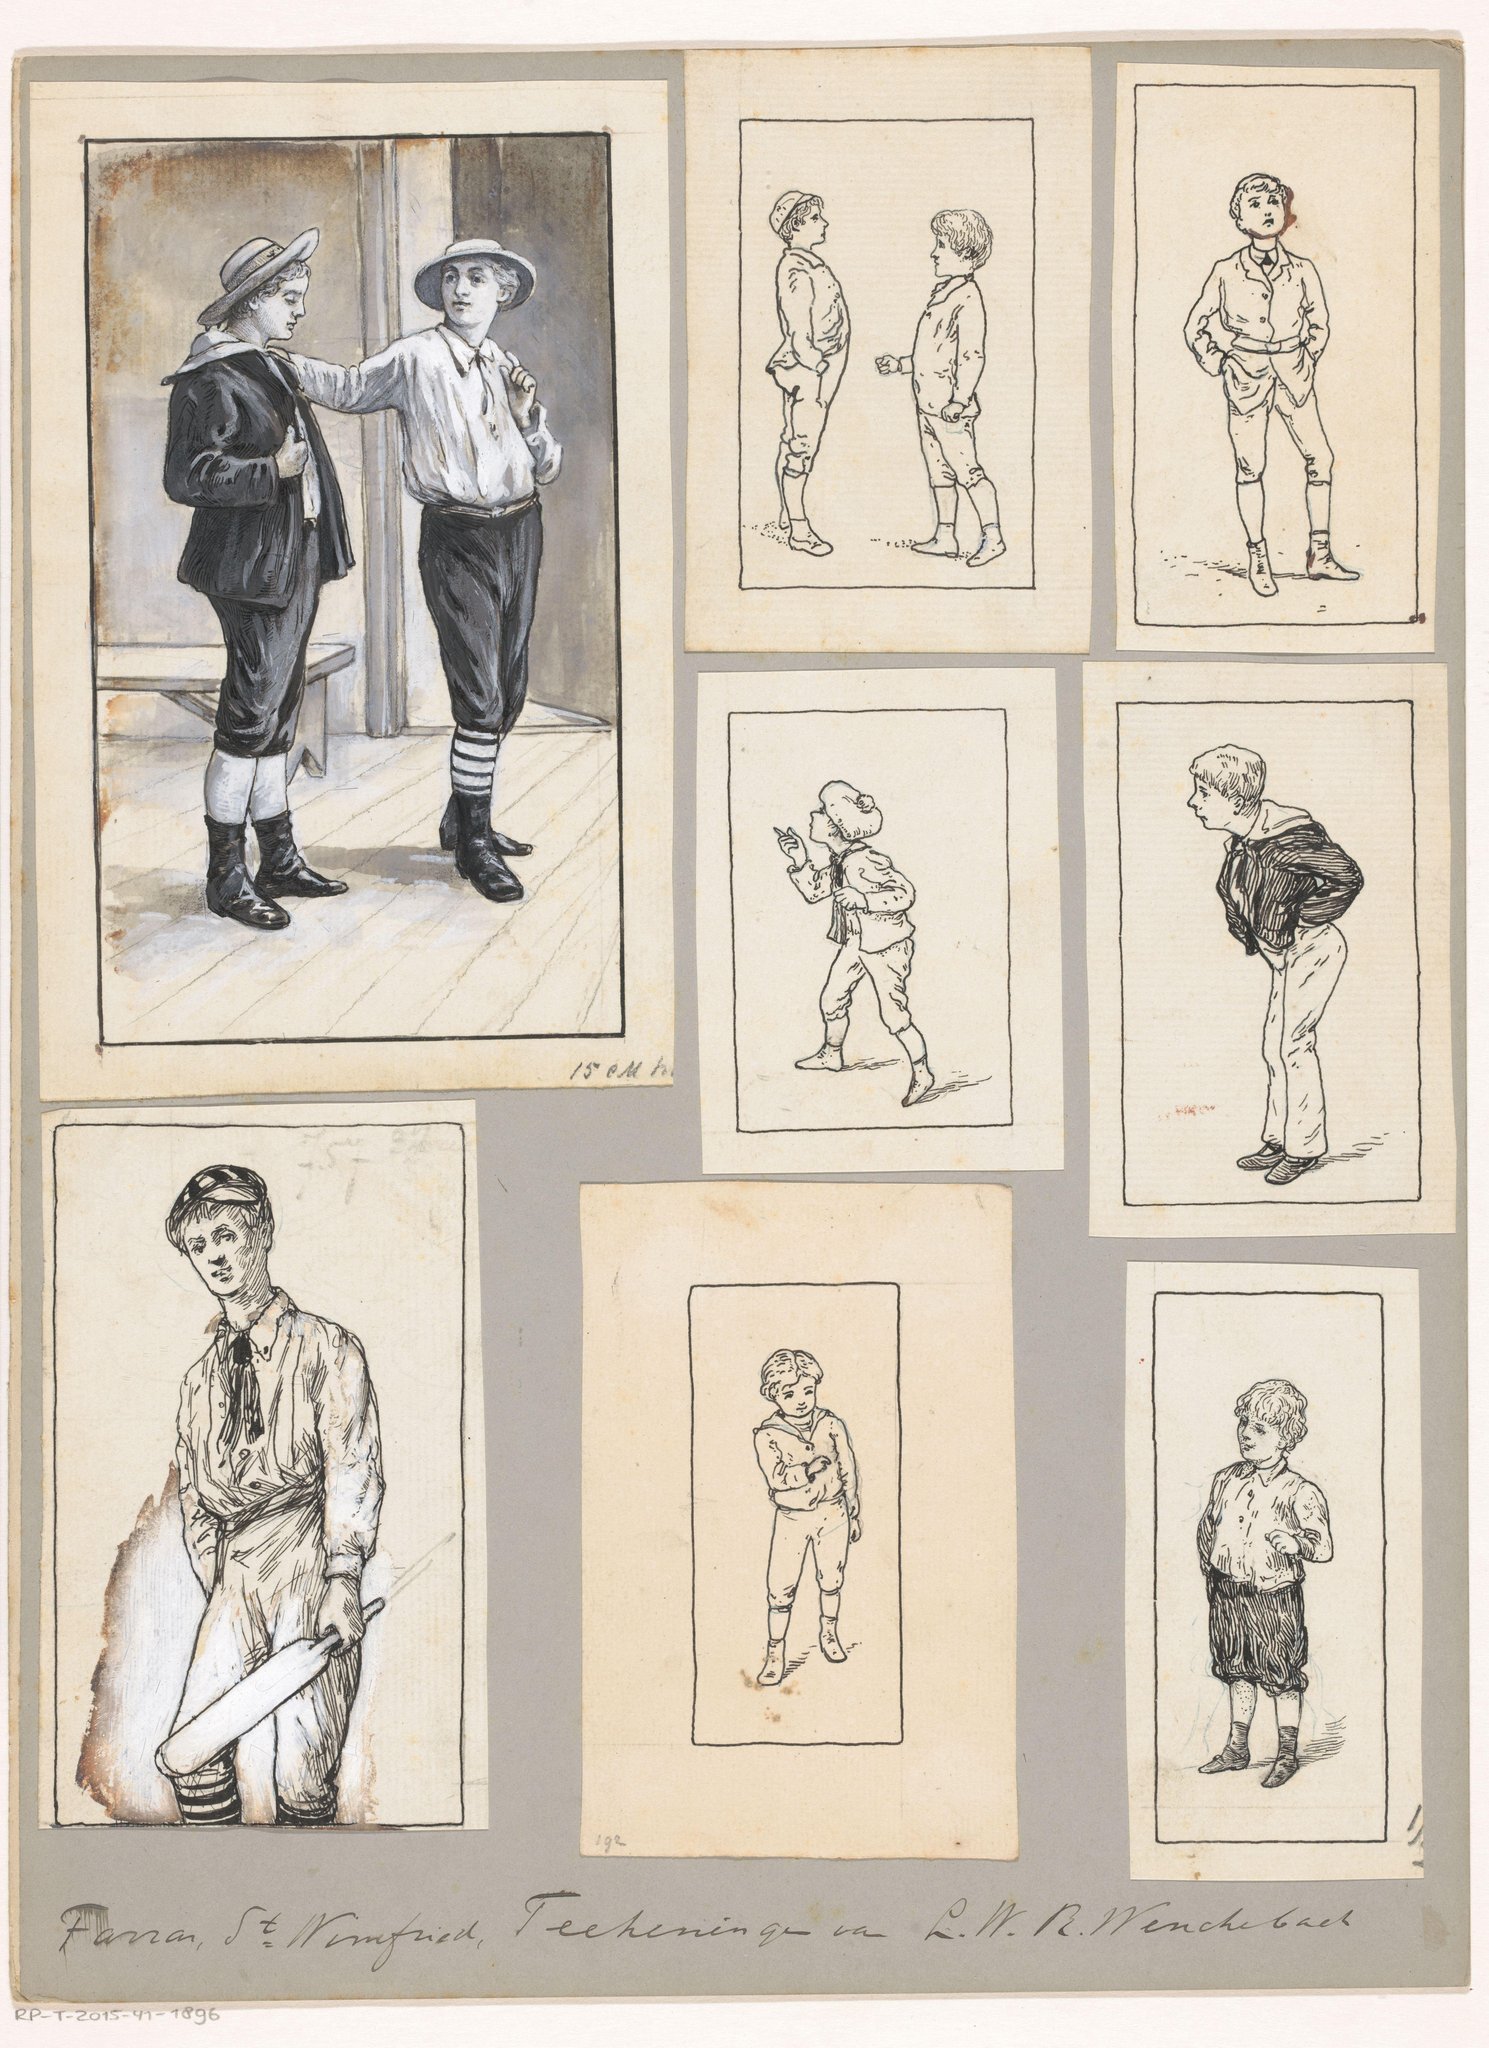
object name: drawing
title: Acht scènes met jongens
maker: willem wenckebach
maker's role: designer, draughtsman, painter, print maker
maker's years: 1860-1937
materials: cardboard, paint, ink, paper, pencil, watercolor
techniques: brush, pen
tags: hand in the pocket - aa - both arms or hands, cricket (ball game) (+ sportsman, player, etc.), boy (child between toddler and youth)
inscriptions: number: ‘192’, annotation: ‘Farrar, St Wimfried Teekeningen van L.W.R. Wenckebach’, :, collector's mark: Lugt 2228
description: Acht ontwerpen voor boekillustraties met onder andere: staande jongens met hoeden, een jongen met een cricketbat en jongens in verschillende lichaamshoudingen, zoals voorovergebogen en met de handen in de zakken.